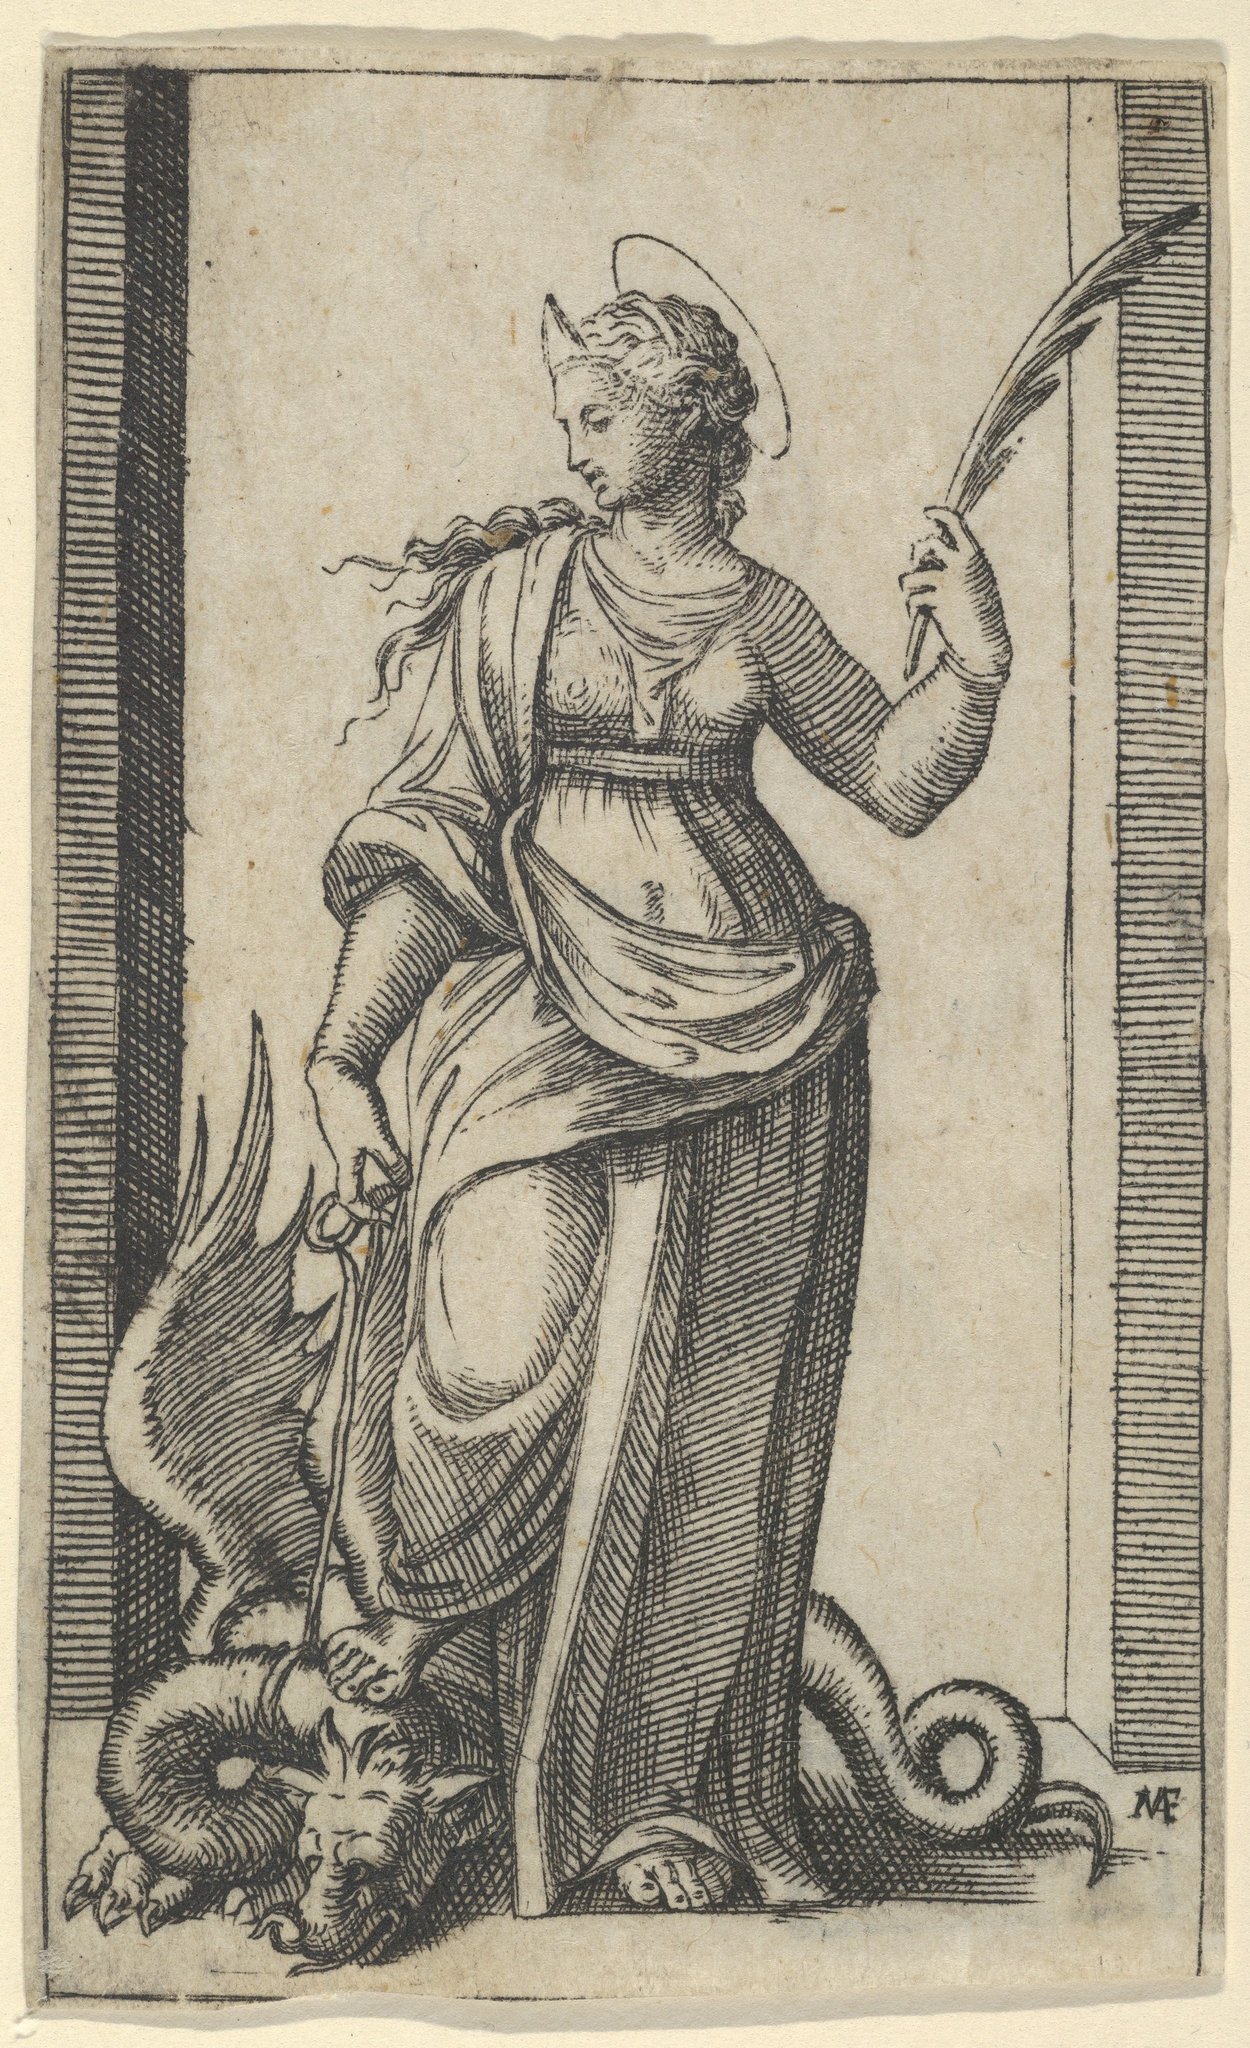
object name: print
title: Saint Margaret standing, a dragon at the left, from "Piccoli Santi" (Small Saints)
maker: marcantonio raimondi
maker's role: artist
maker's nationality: italian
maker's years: 1475-1534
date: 1500-1527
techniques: engraving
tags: women,dragons,saints